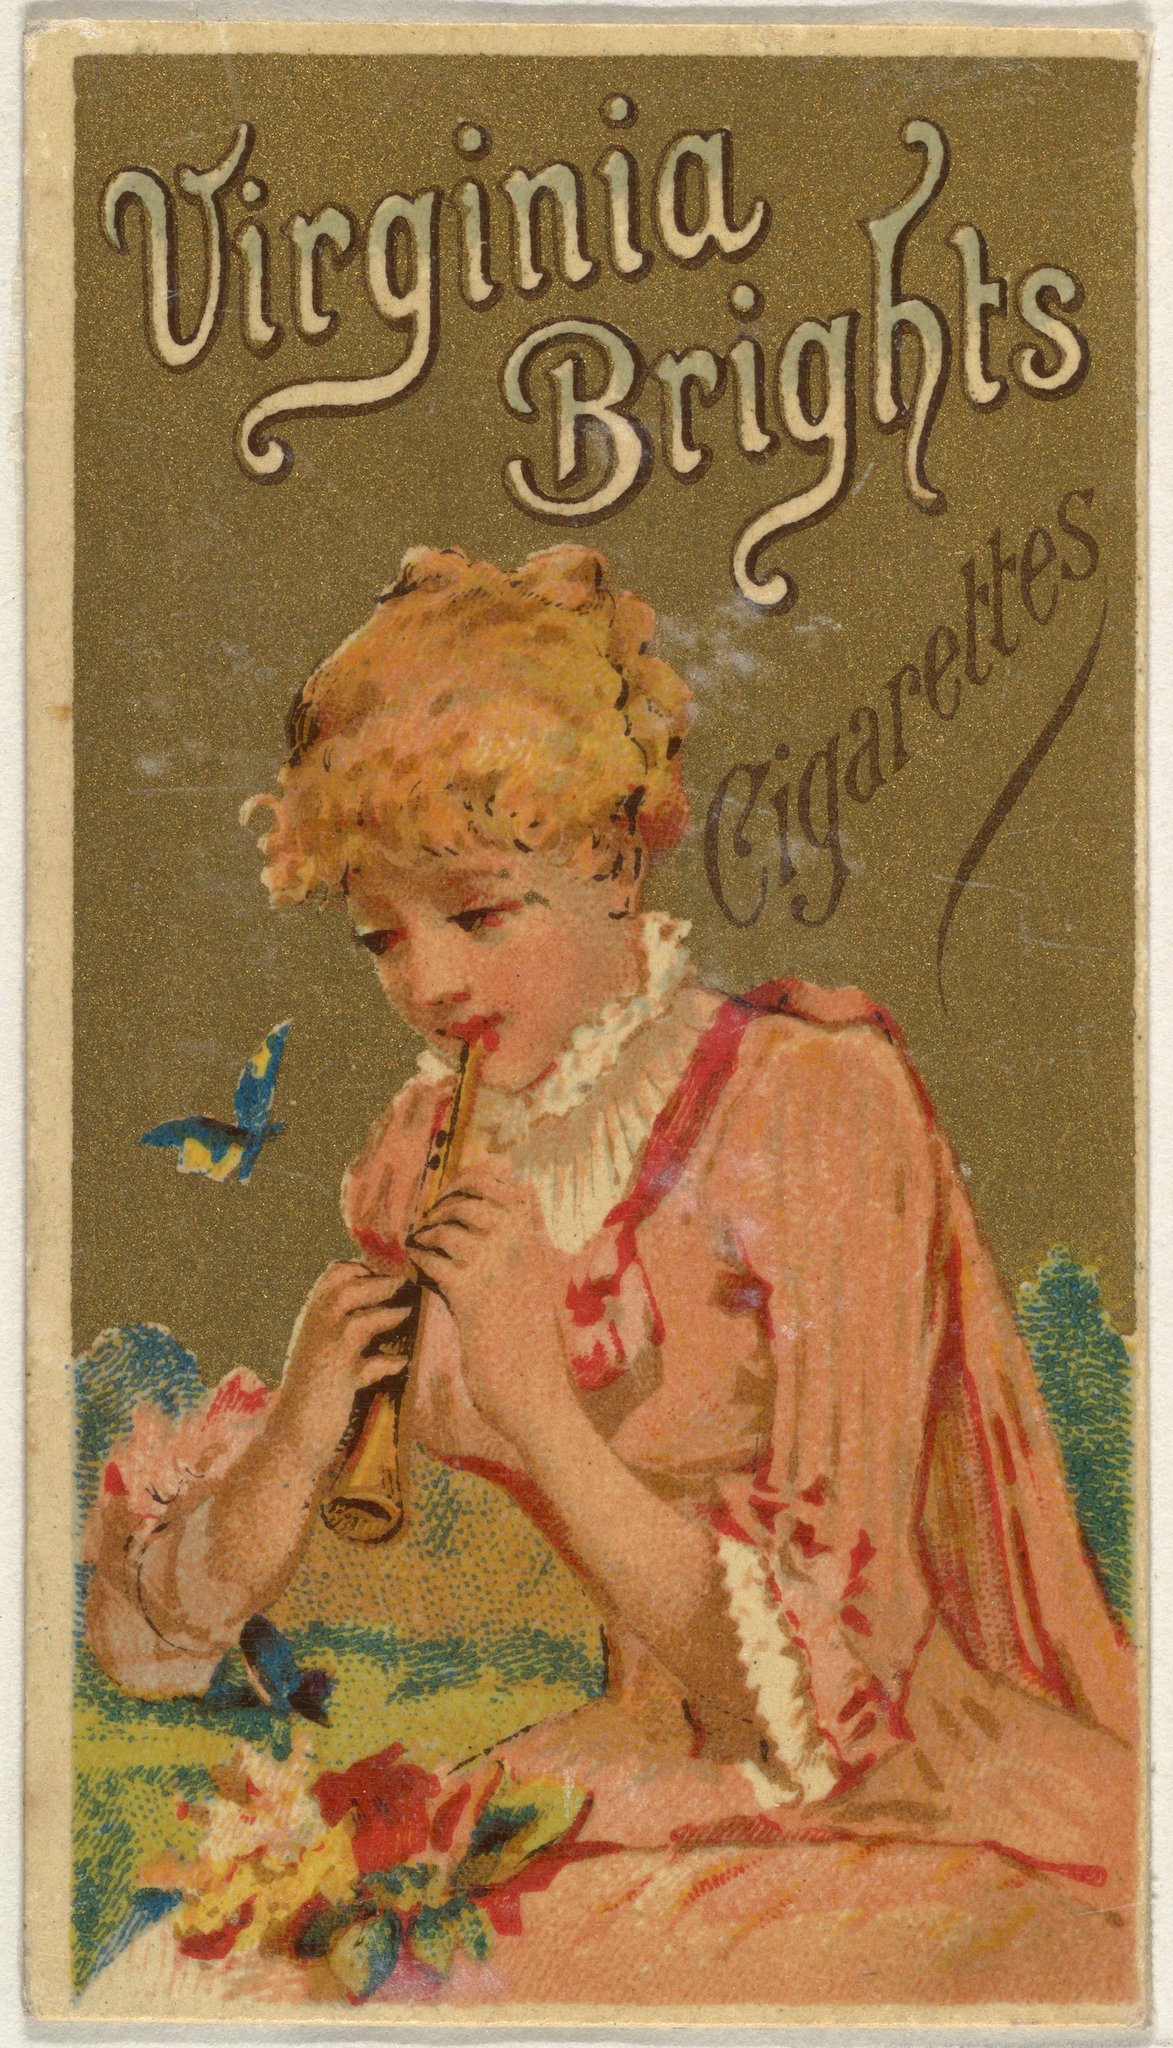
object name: print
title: From the Girls and Children series (N64) promoting Virginia Brights Cigarettes for Allen & Ginter brand tobacco products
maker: allen & ginter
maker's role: publisher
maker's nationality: american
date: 1886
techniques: color lithograph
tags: girls